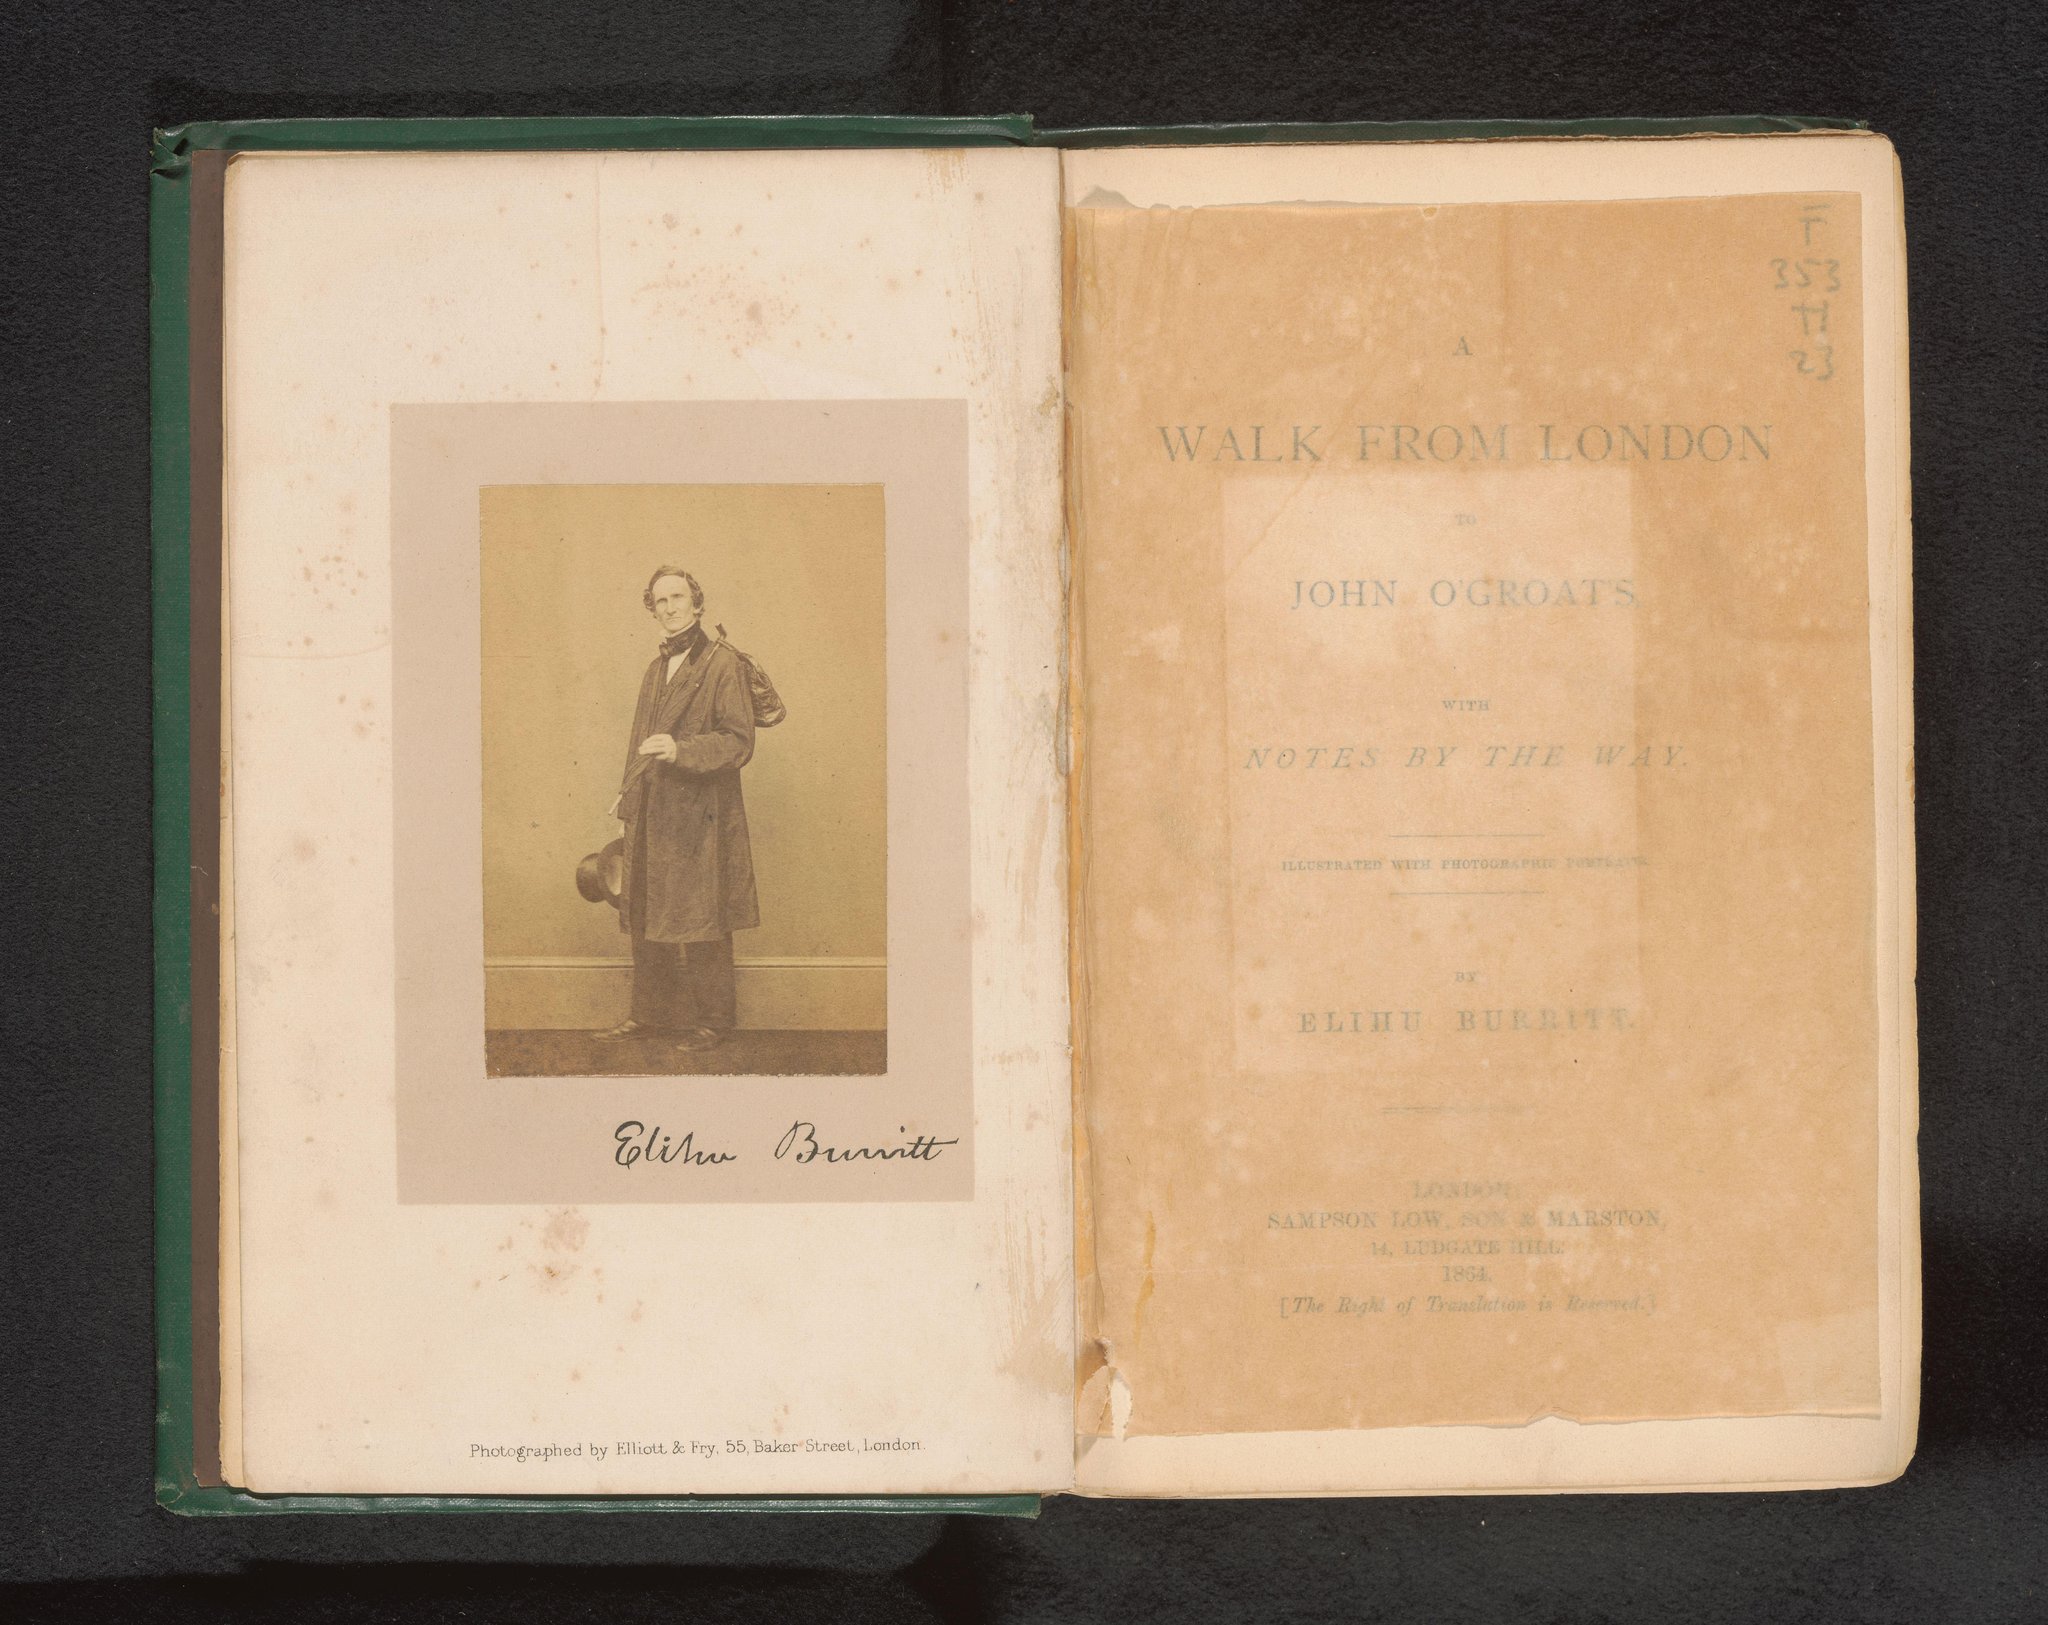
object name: page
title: Portret van Elihu Burritt met een knapzak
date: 1859-1864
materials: photographic support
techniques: albumen print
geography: london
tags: elihu burritt, diplomacy, diplomat, knapsack, rucksack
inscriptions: inscription: ‘Elihu Burritt’, inscription: ‘Photographed by Elliott & Fry, 55, Baker Street, London’